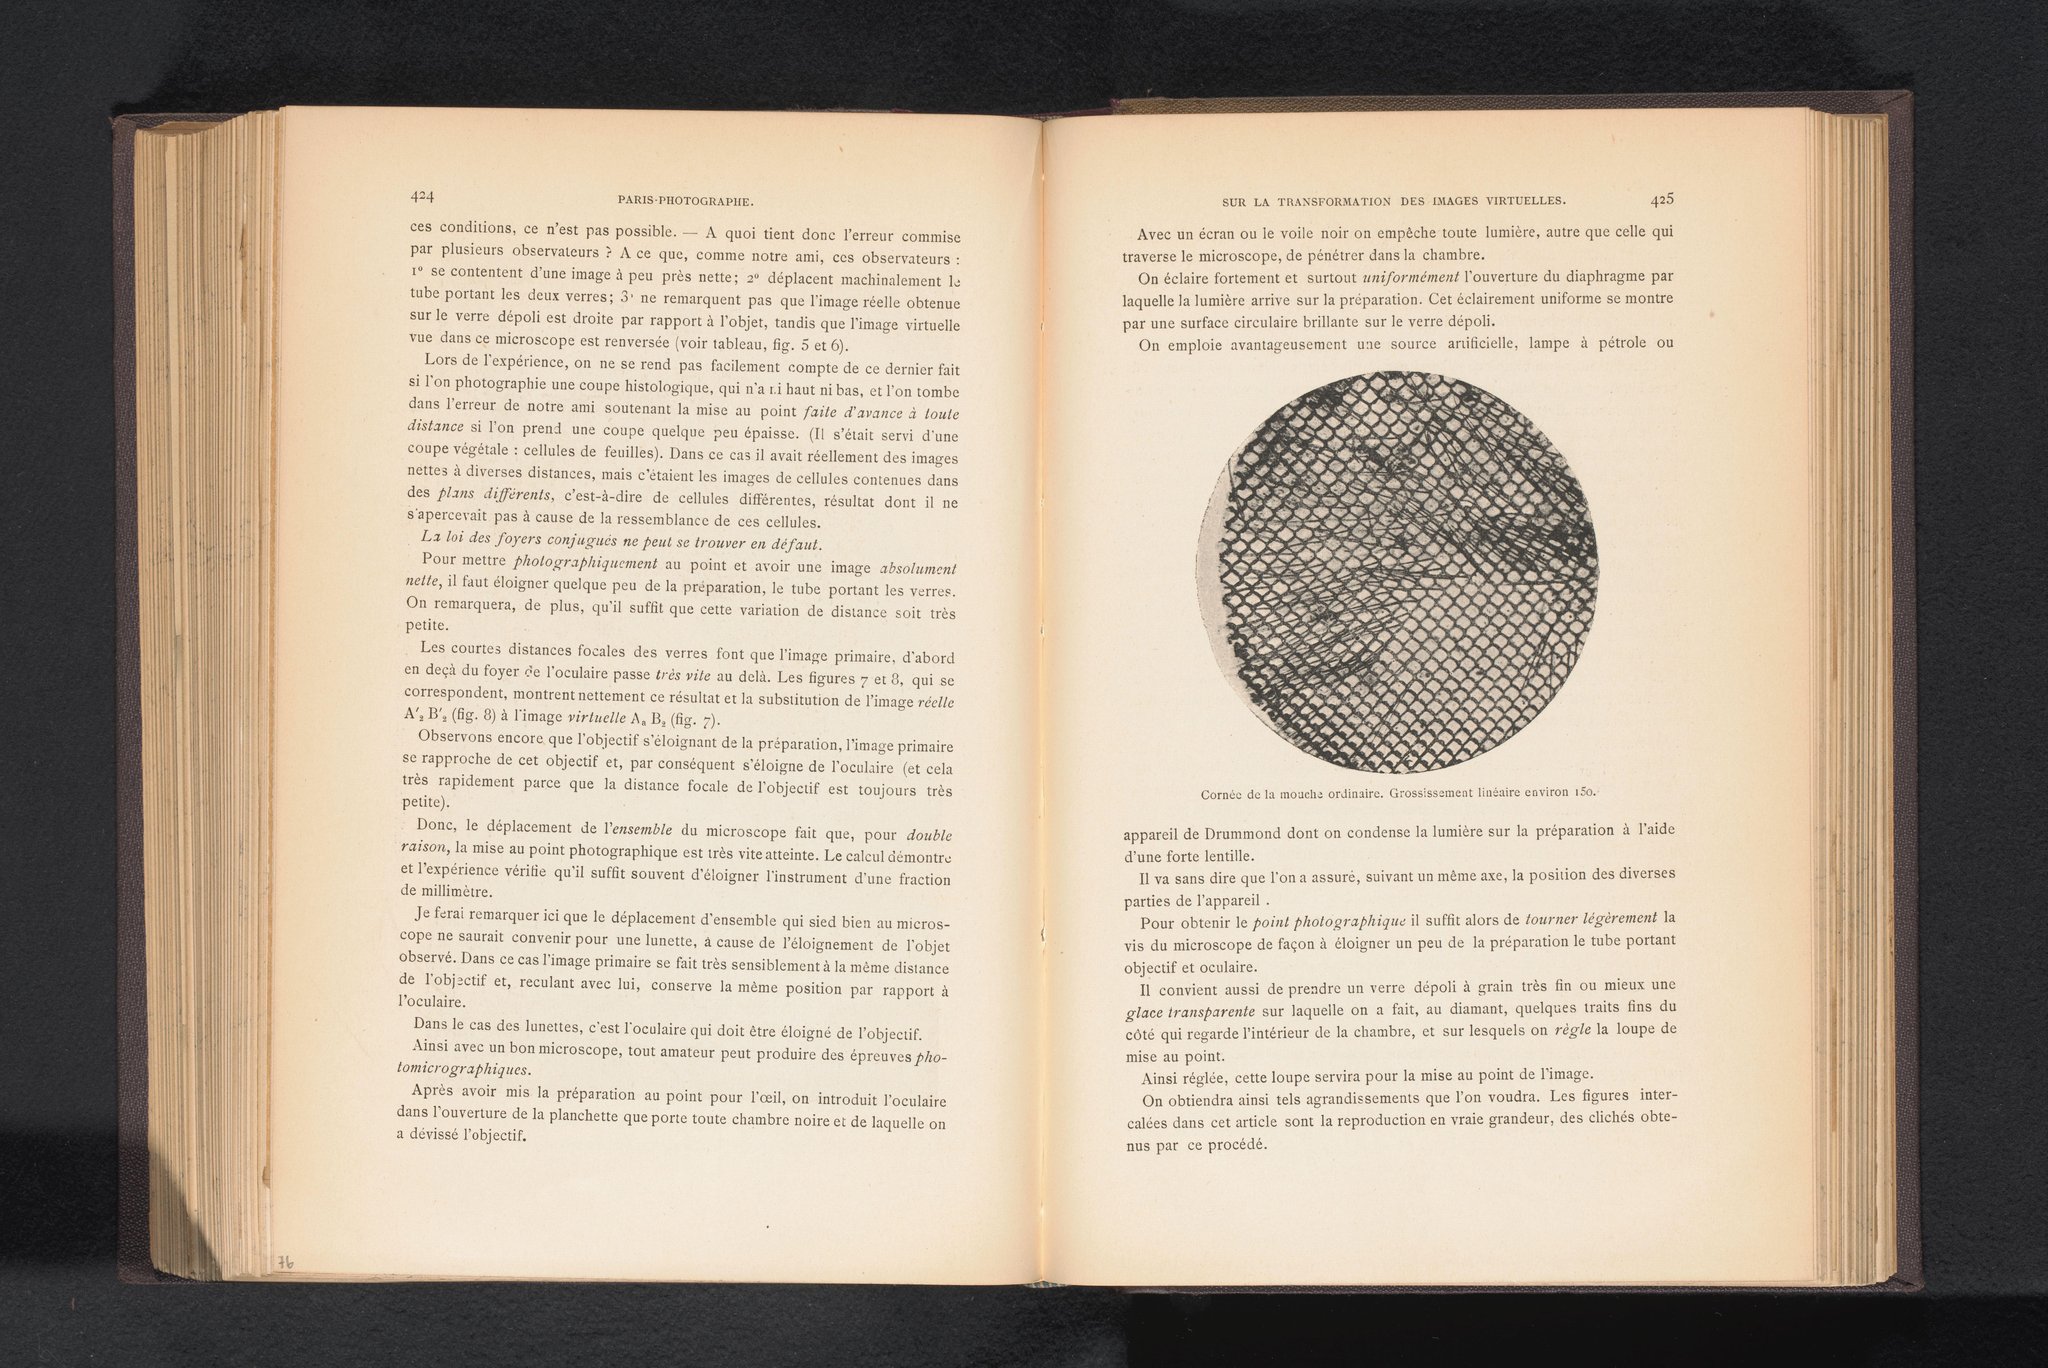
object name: photomechanical print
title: Cornée de la mouche ordinaire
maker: Anonymous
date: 1882-1892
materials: paper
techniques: autotype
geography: france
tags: insects: fly, microscope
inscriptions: inscription: ‘Grossissement linéaire environ 150.’